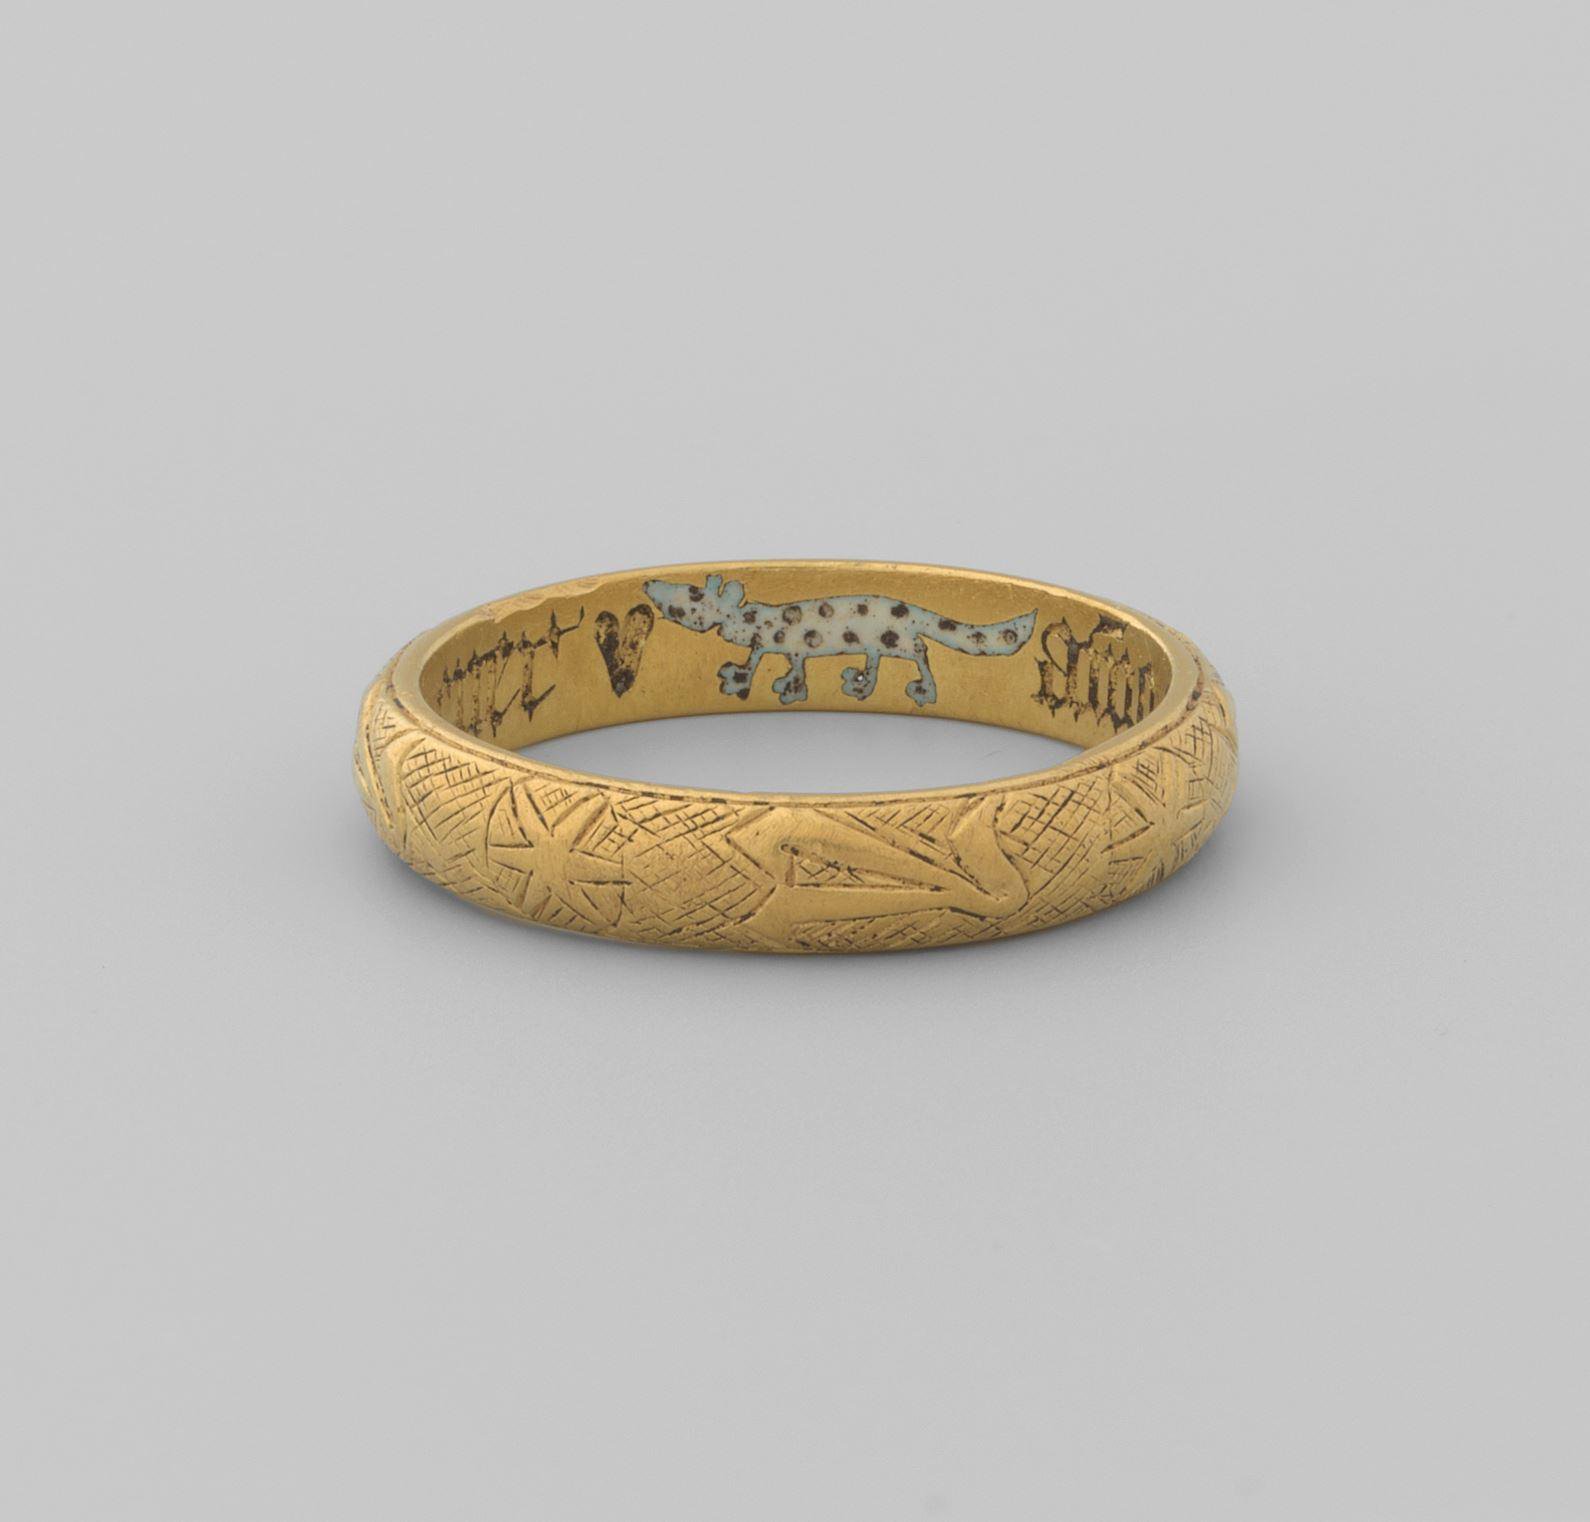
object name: ring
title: Liefdesring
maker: Anonymous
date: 1375-1500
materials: gold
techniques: enameling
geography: paris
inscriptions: inscription: ‘Amours portent mon cuer à mon ami’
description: Gouden ring met aan de binnenzijde een inscriptie: Amours portent mon cuer à mon ami, ofwel ‘Liefde voert mijn hart naar mijn lief'. De dichtregel wordt onderbroken door een zwartgevlekte witte hond en een hartje. De buitenzijde van de ring is gegraveerd met twee repeterende motieven, een Gotische letter Y en en ster.